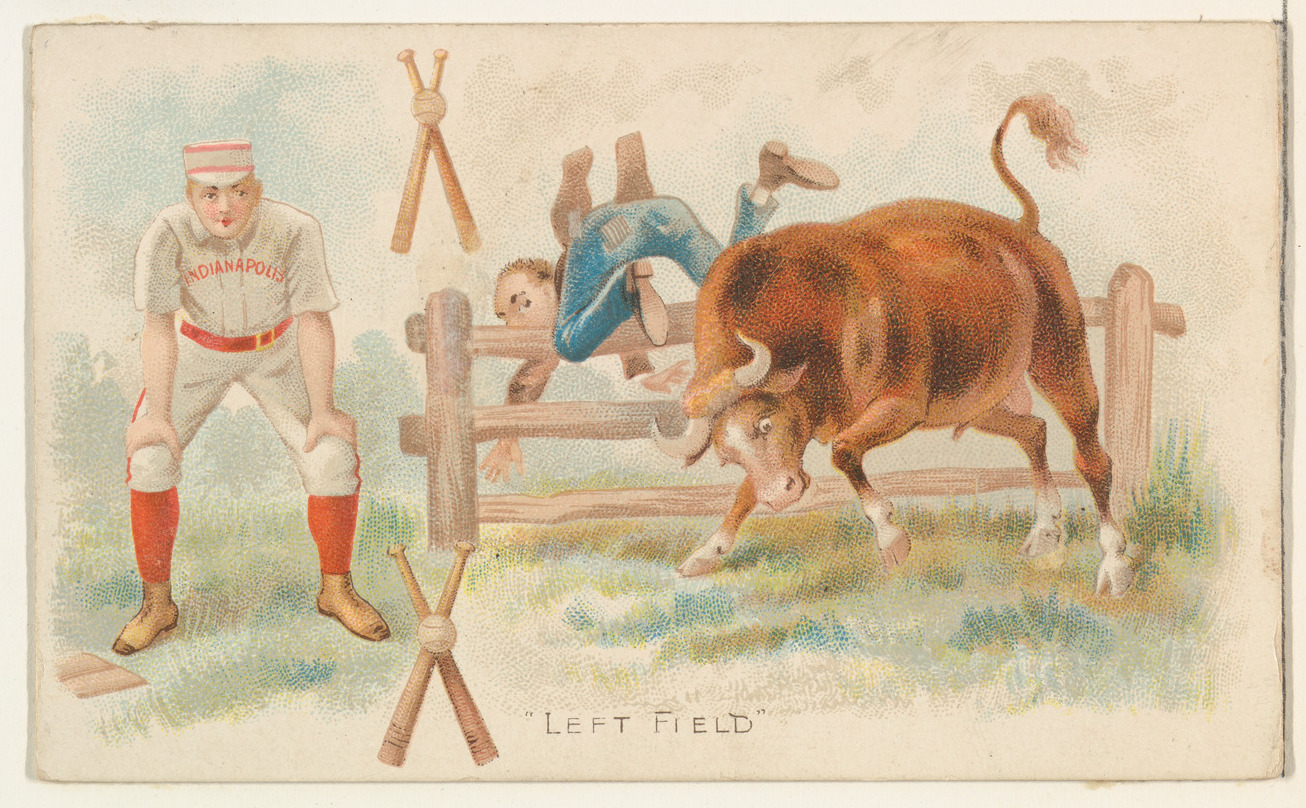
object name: print, baseball card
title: Left Field, from the Talk of the Diamond set (N135) issued by Duke Sons & Co., a branch of the American Tobacco Company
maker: w. duke, sons & co.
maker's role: publisher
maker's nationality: american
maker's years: 1870-1920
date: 1888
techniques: color lithograph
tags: men,bulls